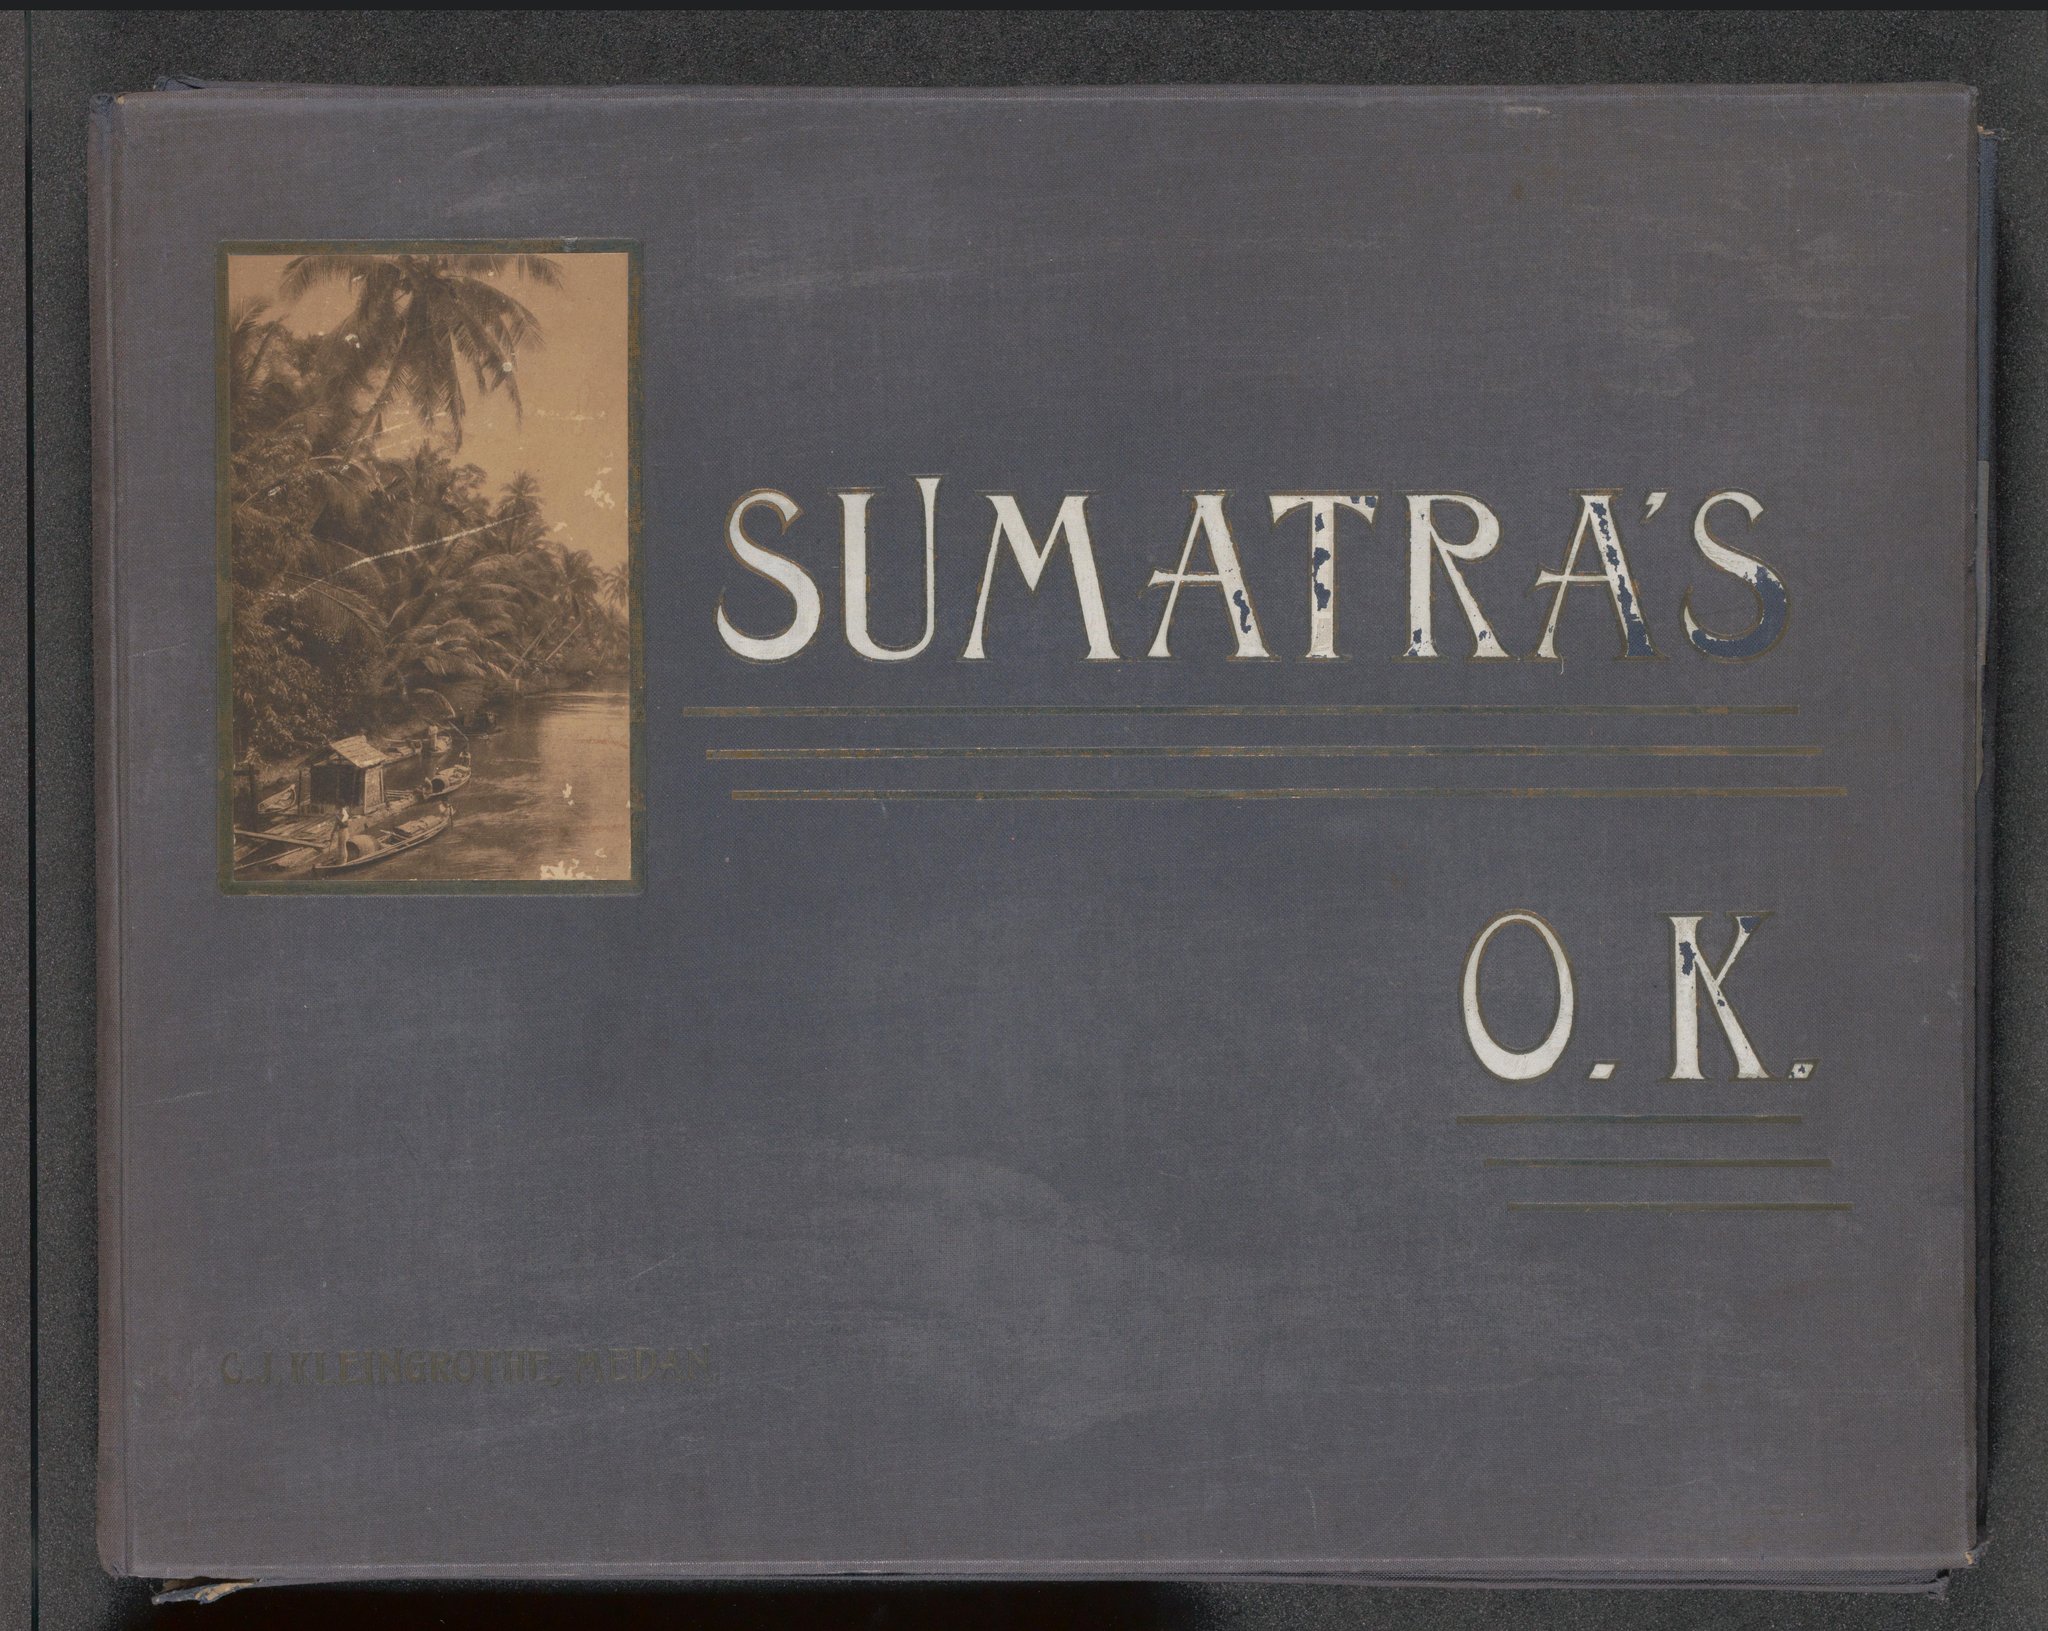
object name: prentrecueil, prentenalbum, prentalbum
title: Sumatra's O.K.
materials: cardboard, linen, paper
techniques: photoaquatint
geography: munich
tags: plantation, oil; oil refinery, tobacco, sumatra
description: Portefeuille met op de voorkant de naam van de fotograaf, de titel (waarbij 'O.K.' voor 'oostkust' staat) en een heliogravure van een rivieroever met boten. Schutblad en de stofflappen hebben een geometrisch motief. Het album bevatte oorspronkelijk 65 bladen met heliogravures. Twee bladen (record RP-F-AA3189-18 en RP-F-AA3189-53) zijn in het verleden voorzien van passe-partouts en onder een andere standplaats opgeborgen in de Rijksmuseumcollectie. De prenten geven een beeld van de bedrijvigheid aan de oostkust van Sumatra, waar veel koffie- en rubberplantages van Nederlandse kolonisten waren, alsmede olievelden. Ook zijn er opnames van stads- en dorpsgezichten, landschappen en van de Indische bevolking van het eiland.